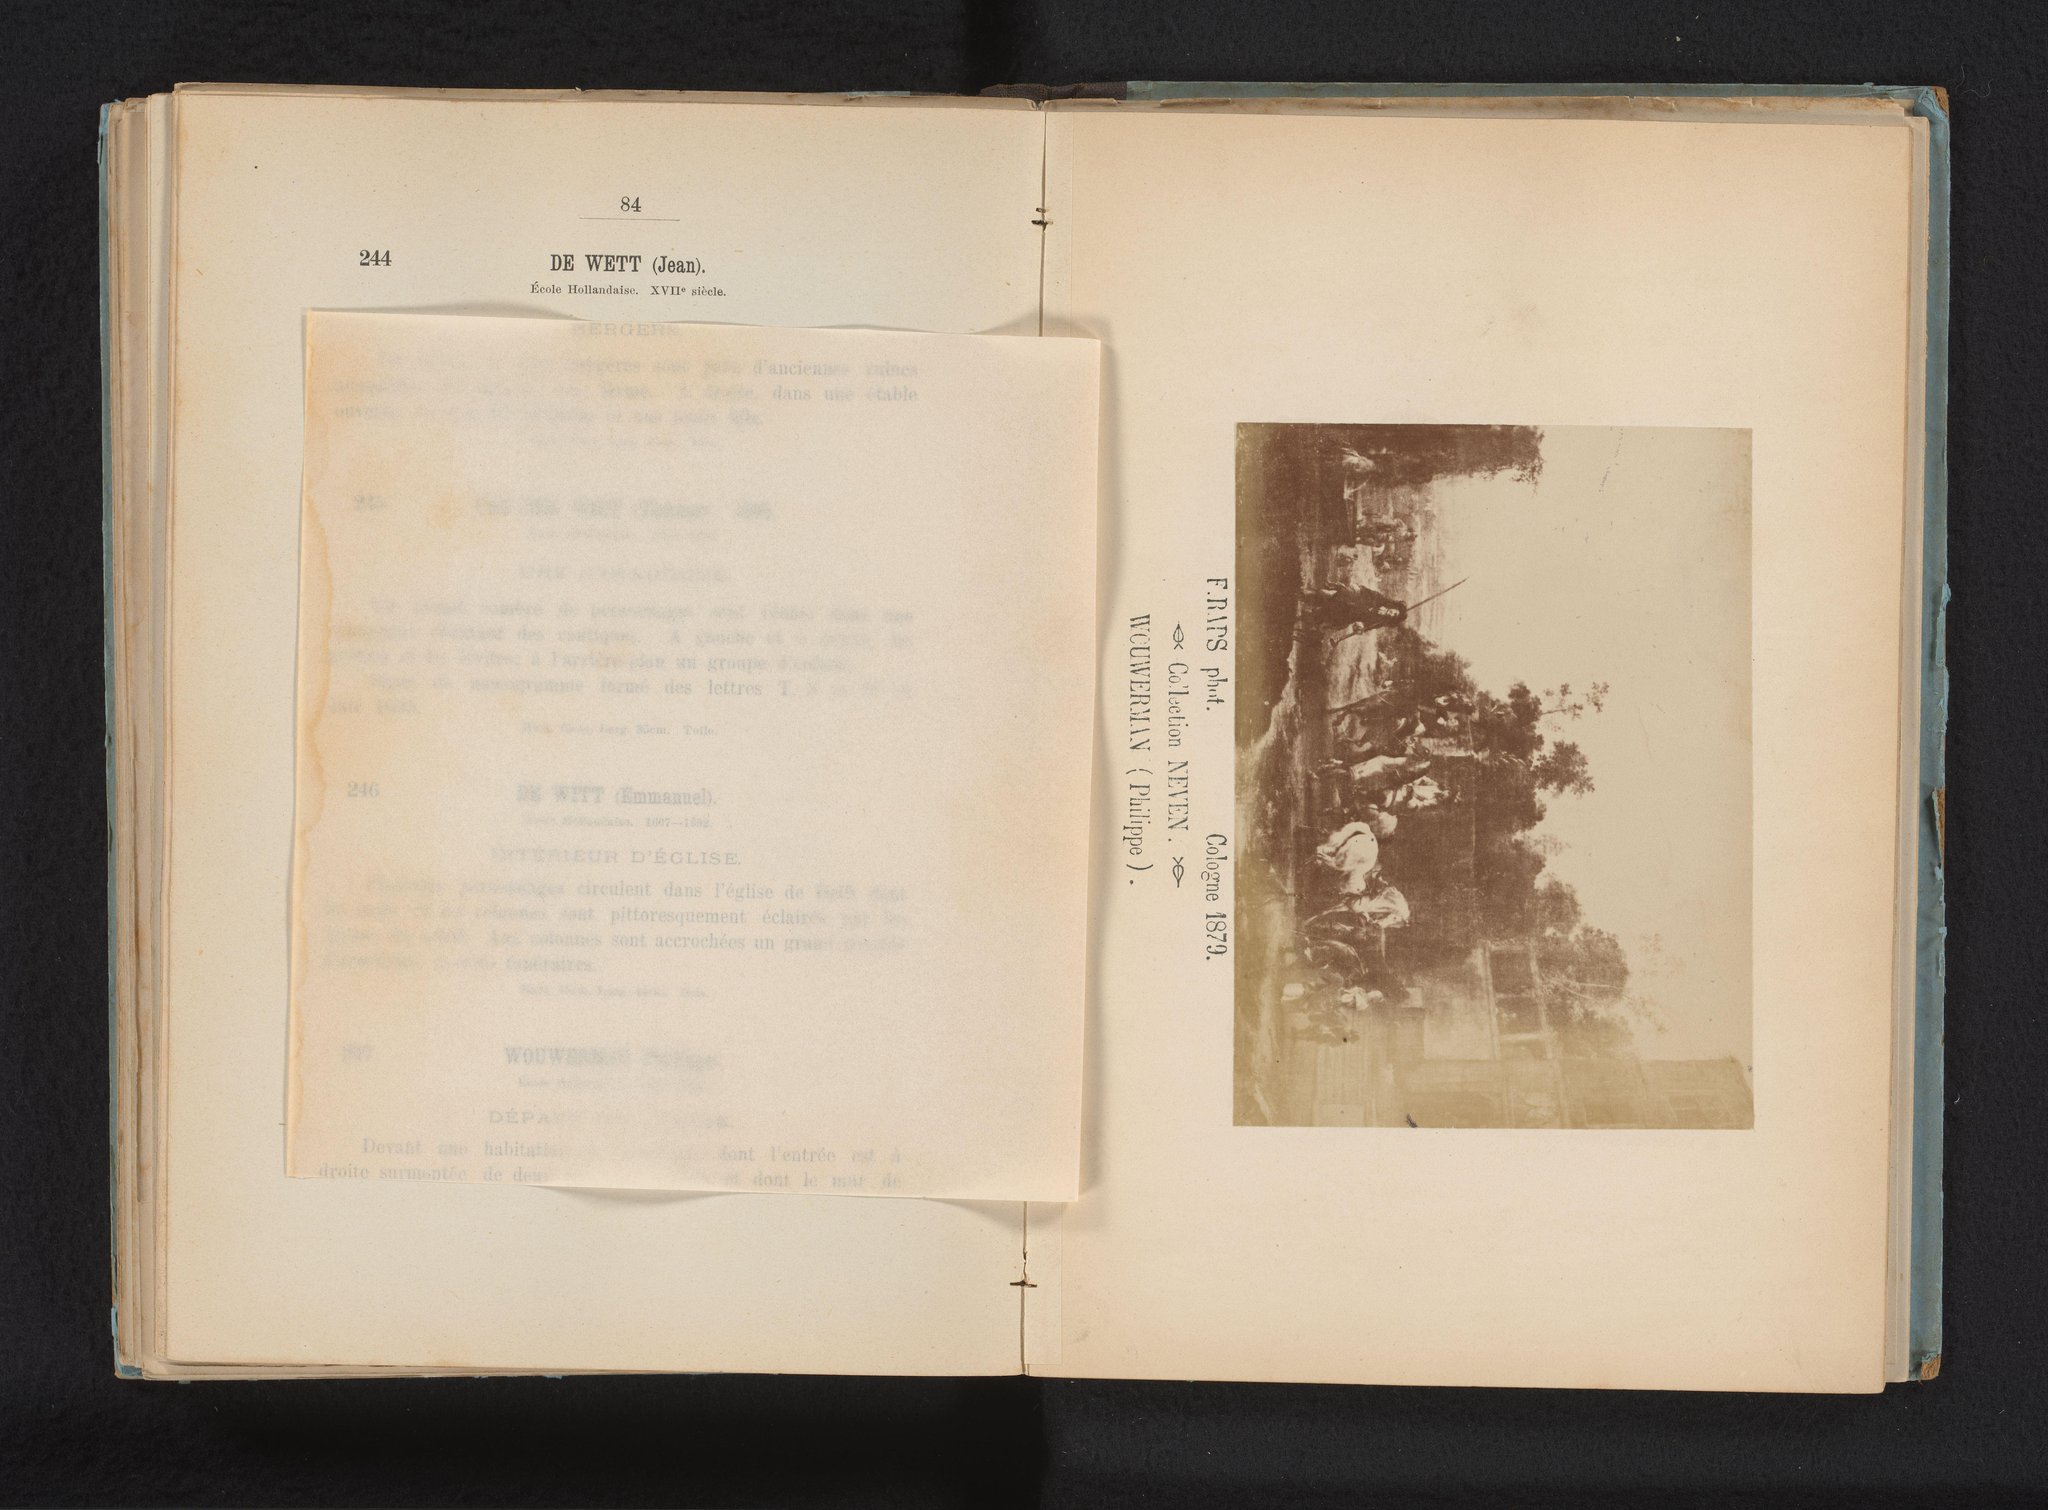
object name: photograph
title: Fotoreproductie van een schilderij van een vertrekkend jachtgezelschap bij een landhuis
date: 1879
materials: photographic support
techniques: albumen print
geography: cologne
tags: assembling, 'départ pour la chasse'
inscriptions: inscription: ‘Collection NEVEN/ Wouwerman (Philippe)’